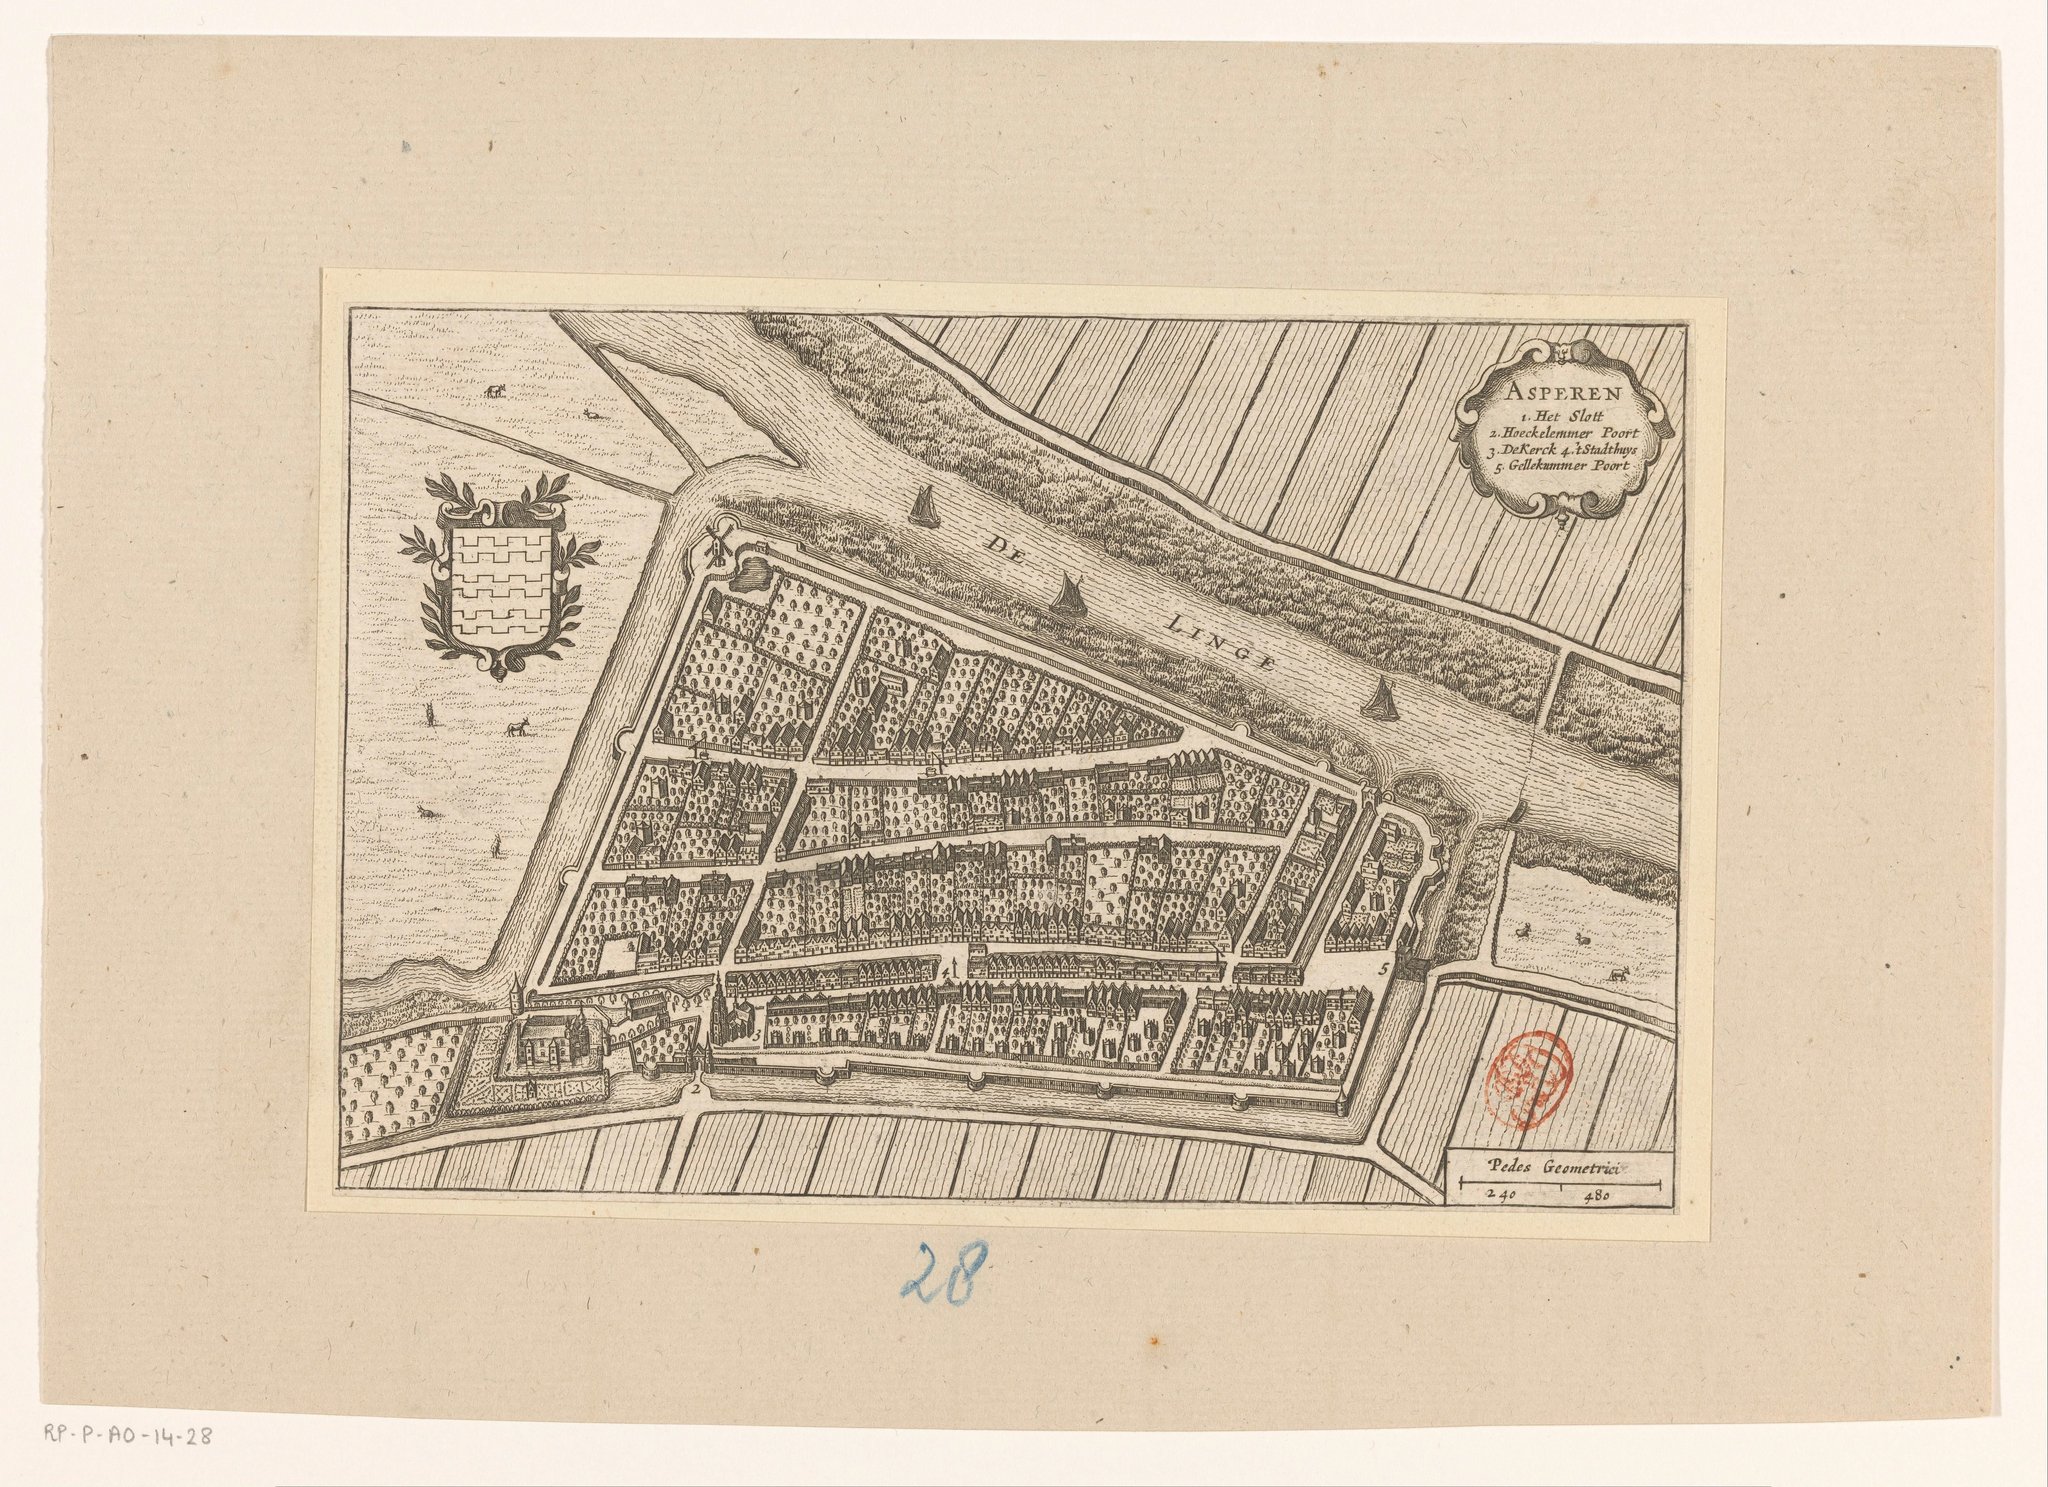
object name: area plan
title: Plattegrond van Asperen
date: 1632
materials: paper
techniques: engraving, etching, letterpress printing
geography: amsterdam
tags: coat of arms (as symbol of the state, etc.) (+ city; municipal), maps of cities, asperen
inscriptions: collector's mark: Lugt 195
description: Prent gebruikt in: Blaeu, Johannes Willemszoon. Toonneel der steden van de Vereenighde Nederlanden. 2 delen. Amsterdam: Johannes Willemszoon Blaeu, 1652, dl. 1. Prent voor het eerst ook gebruikt in: Boxhorn, Marcus Zuerius van. Theatrum sive Hollandiae comitatus et urbium nova descriptio (…). Amsterdam: Henricus Hondius, 1632.